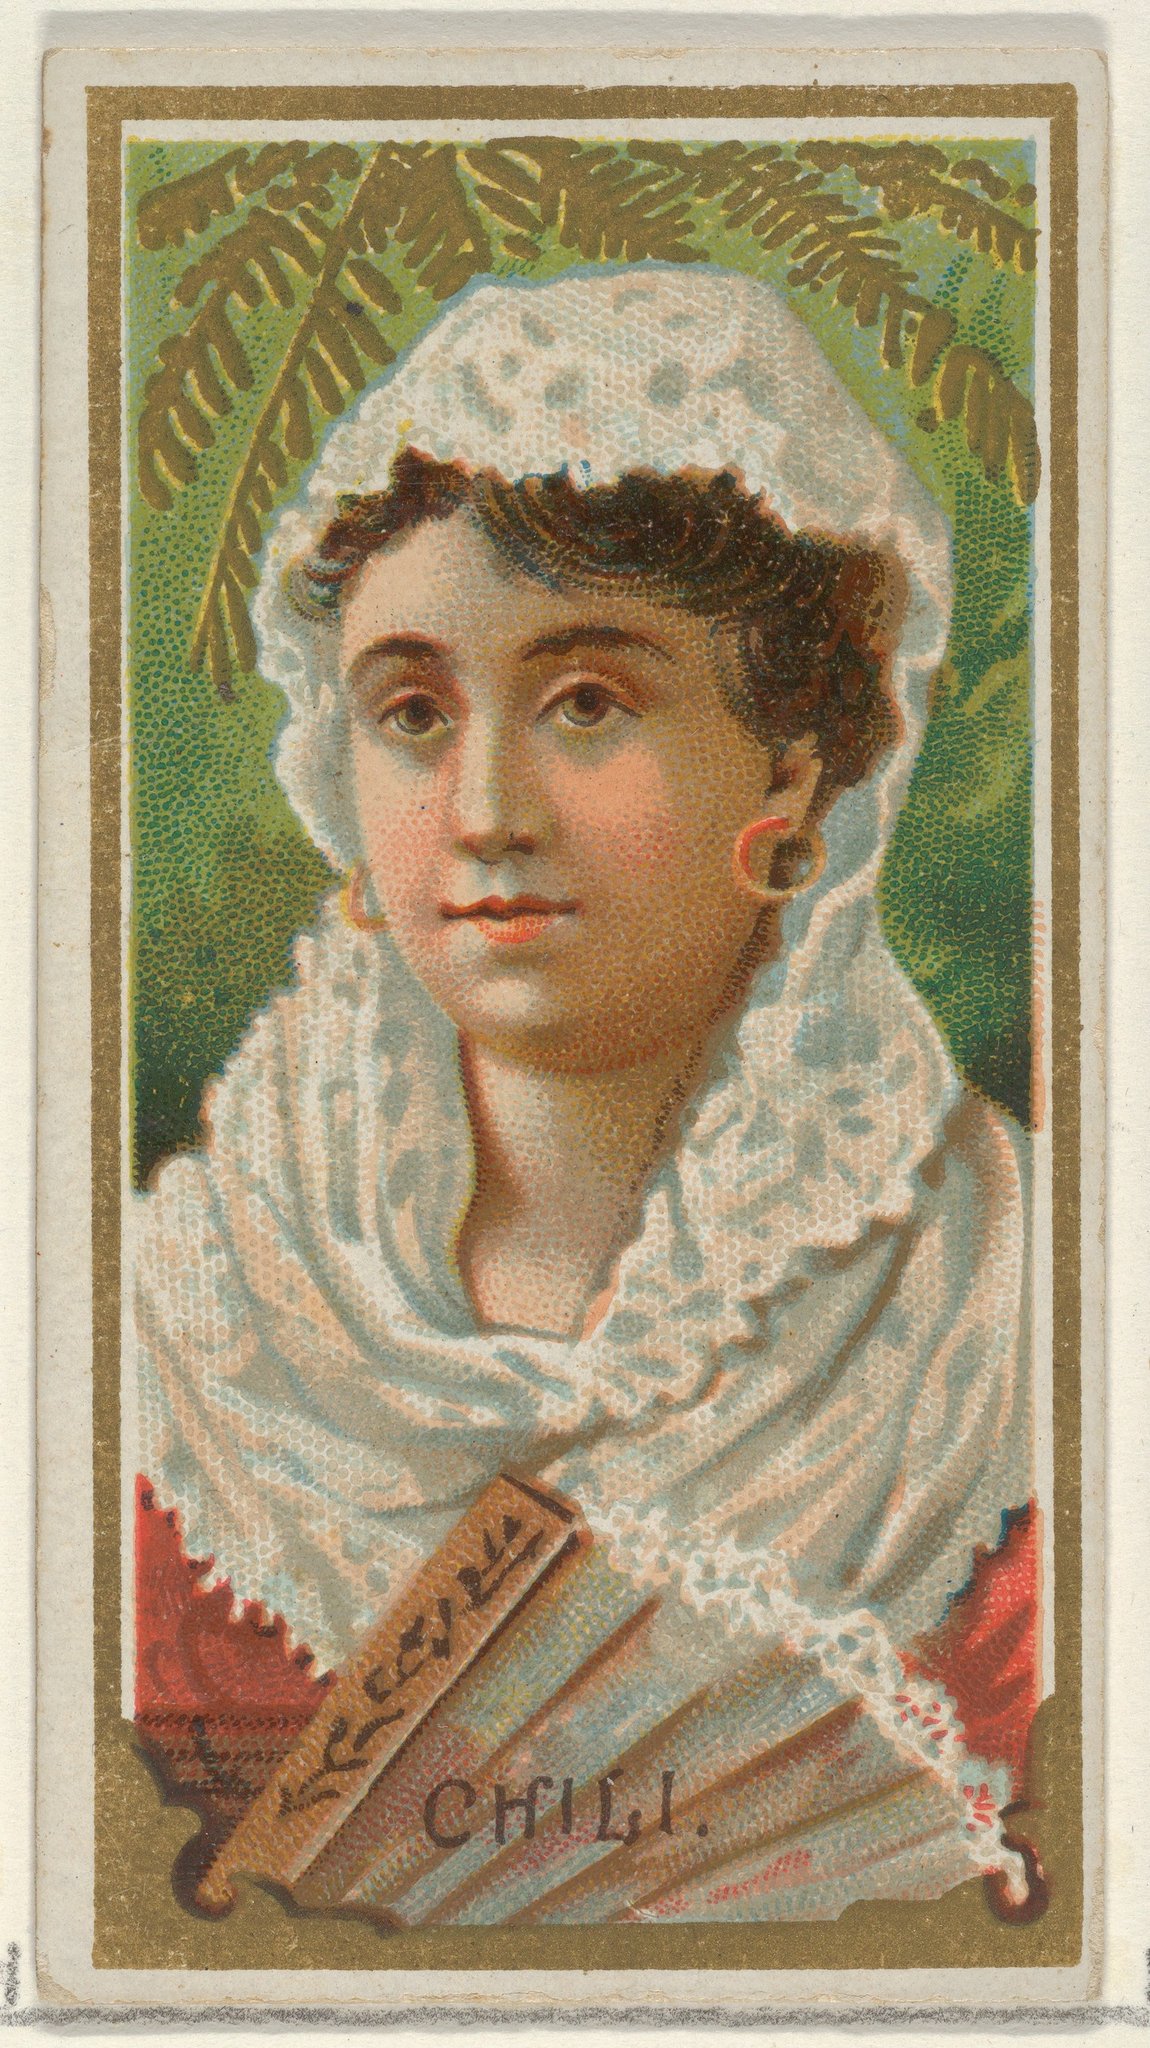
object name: print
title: Chili, from the Types of All Nations series (N24) for Allen & Ginter Cigarettes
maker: allen & ginter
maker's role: publisher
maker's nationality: american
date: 1889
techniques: color lithograph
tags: women